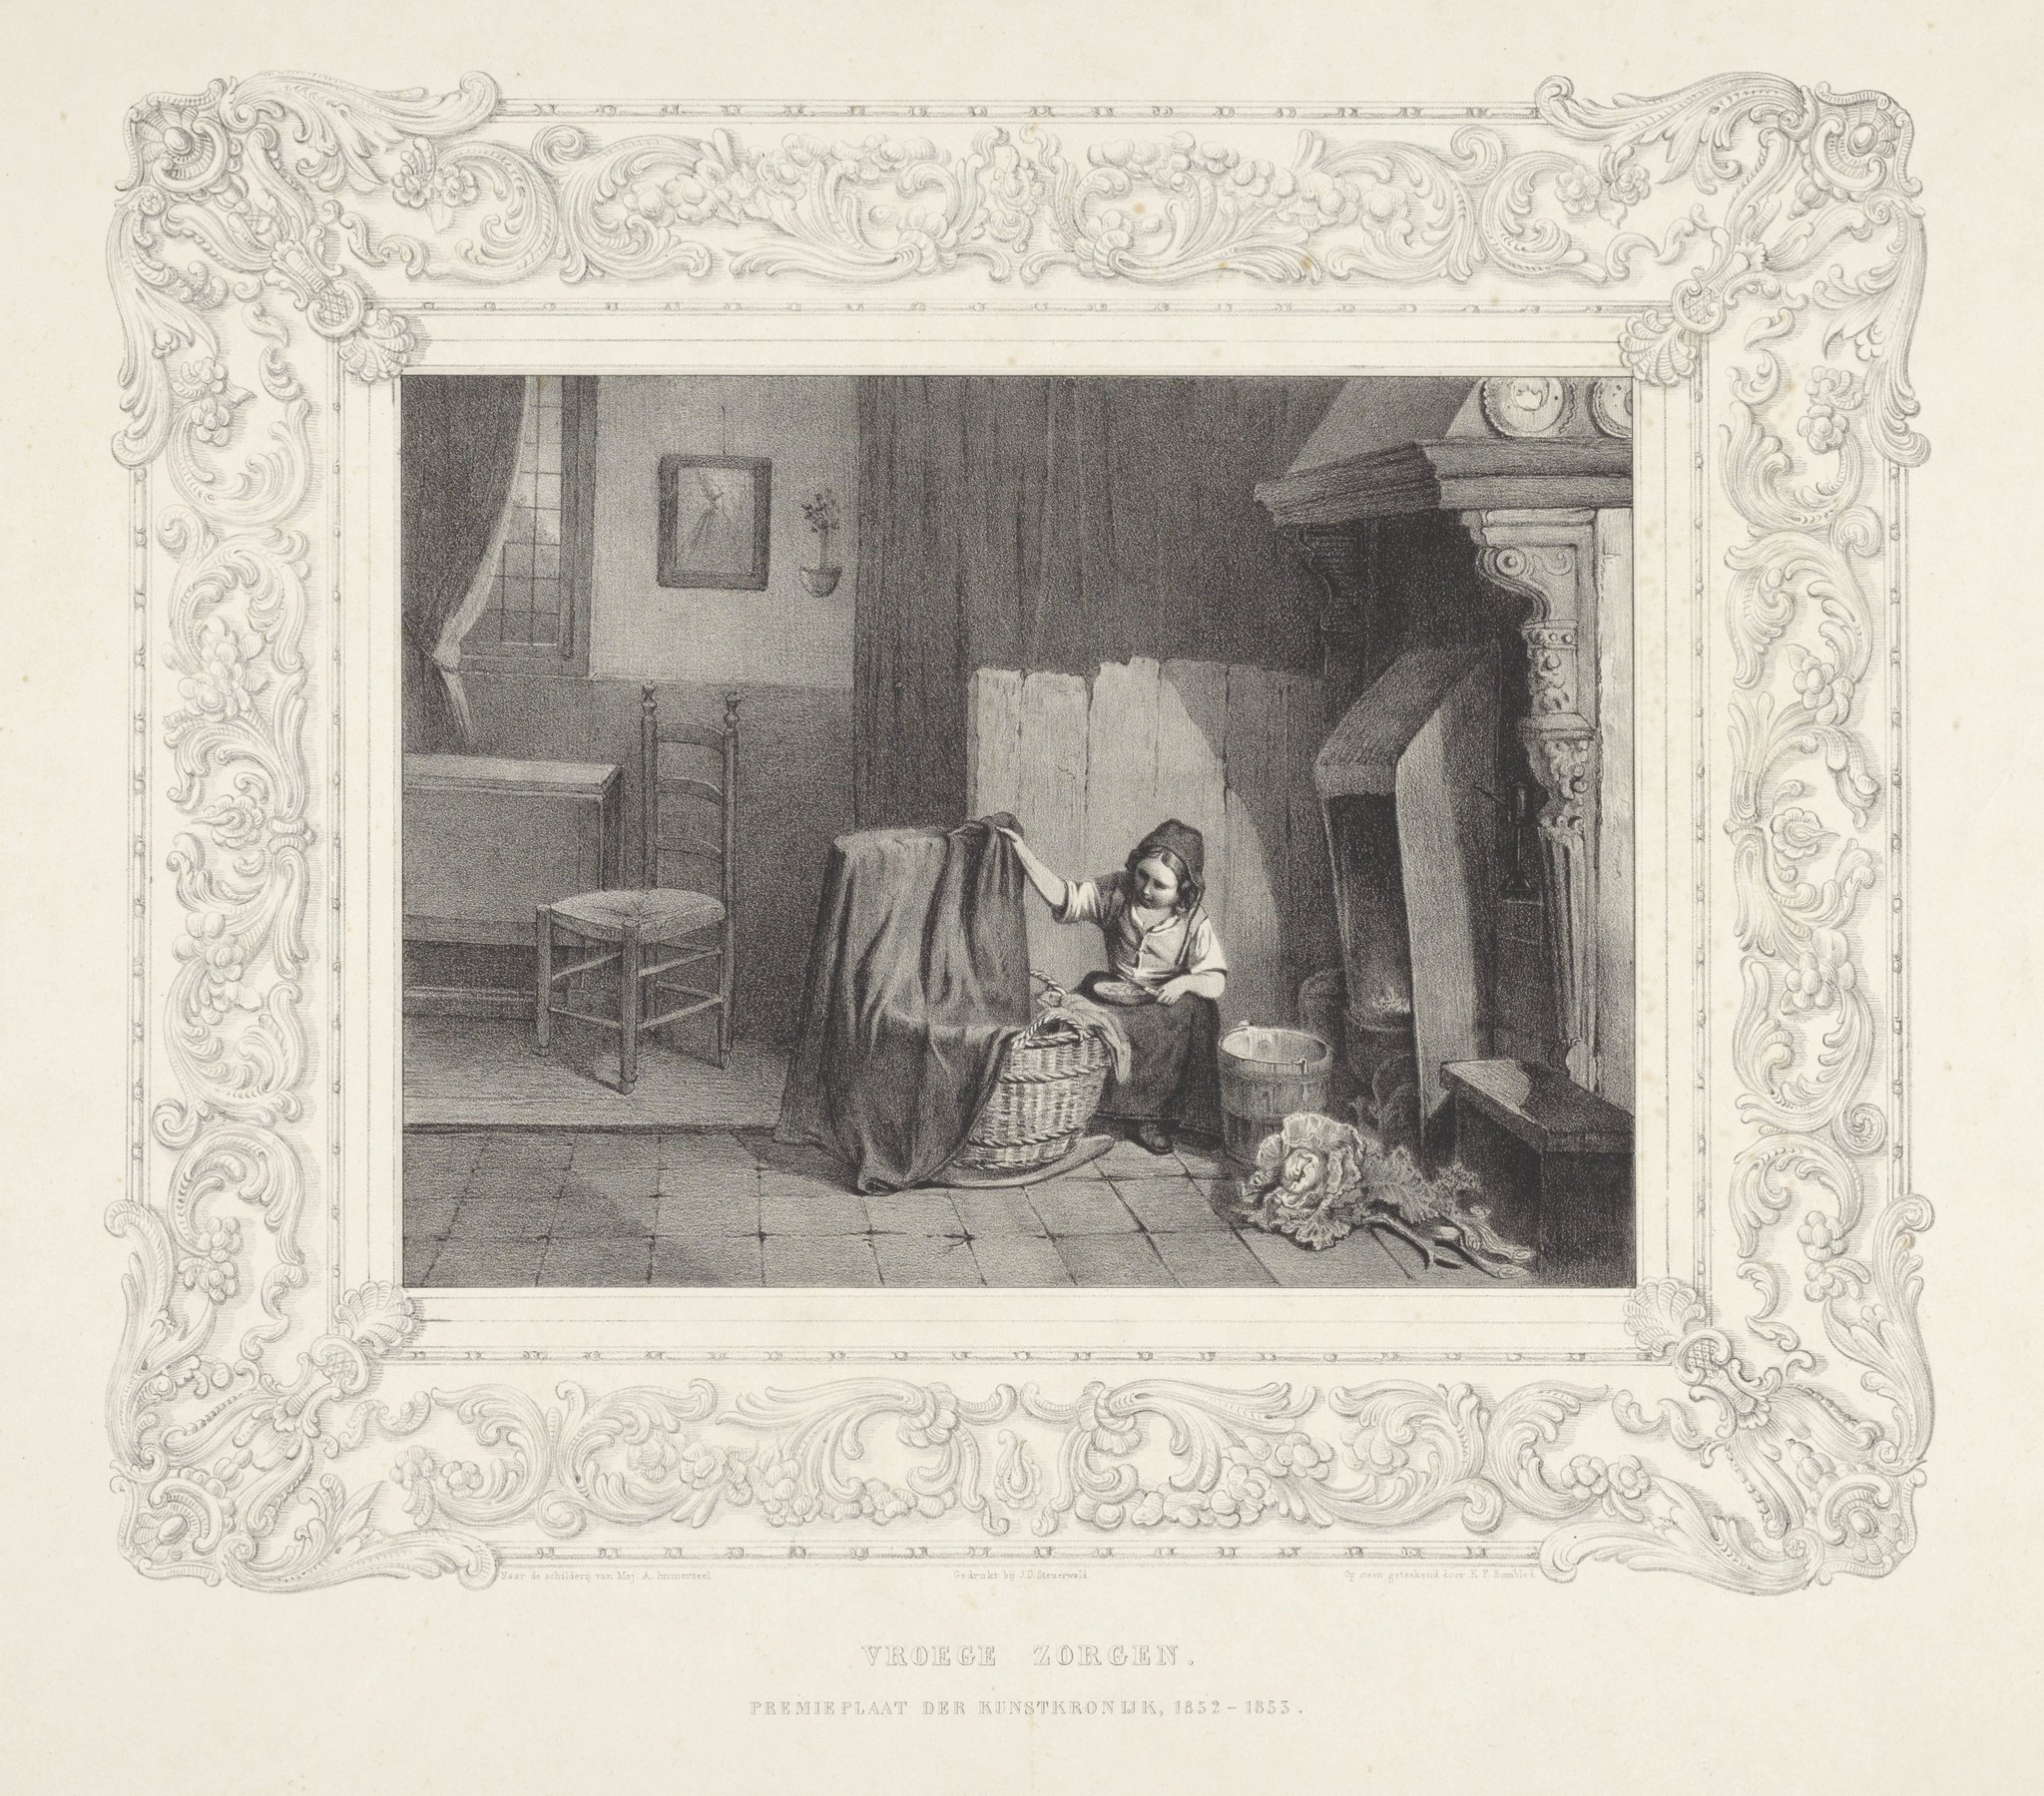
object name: print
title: Vroege zorgen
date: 1832-1862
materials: paper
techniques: lithograph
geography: the hague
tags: rocking the cradle (children's game), open hearth, fire-place, mother and baby or young child, plants and herbs: cabbage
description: Een jonge moeder zit naast de open haard bij een wieg. In haar schoot een bord met eten en een mes. Met haar rechterhand beweegt ze de wieg op en neer. Voor de haard een lege emmer, een kool en takken. Om de afbeelding een sierlijst bestaande uit bladmotieven. Naar een schilderij van Anna Maria Immerzeel. Premieplaat bij De Kunstkroniek 1852-1853.